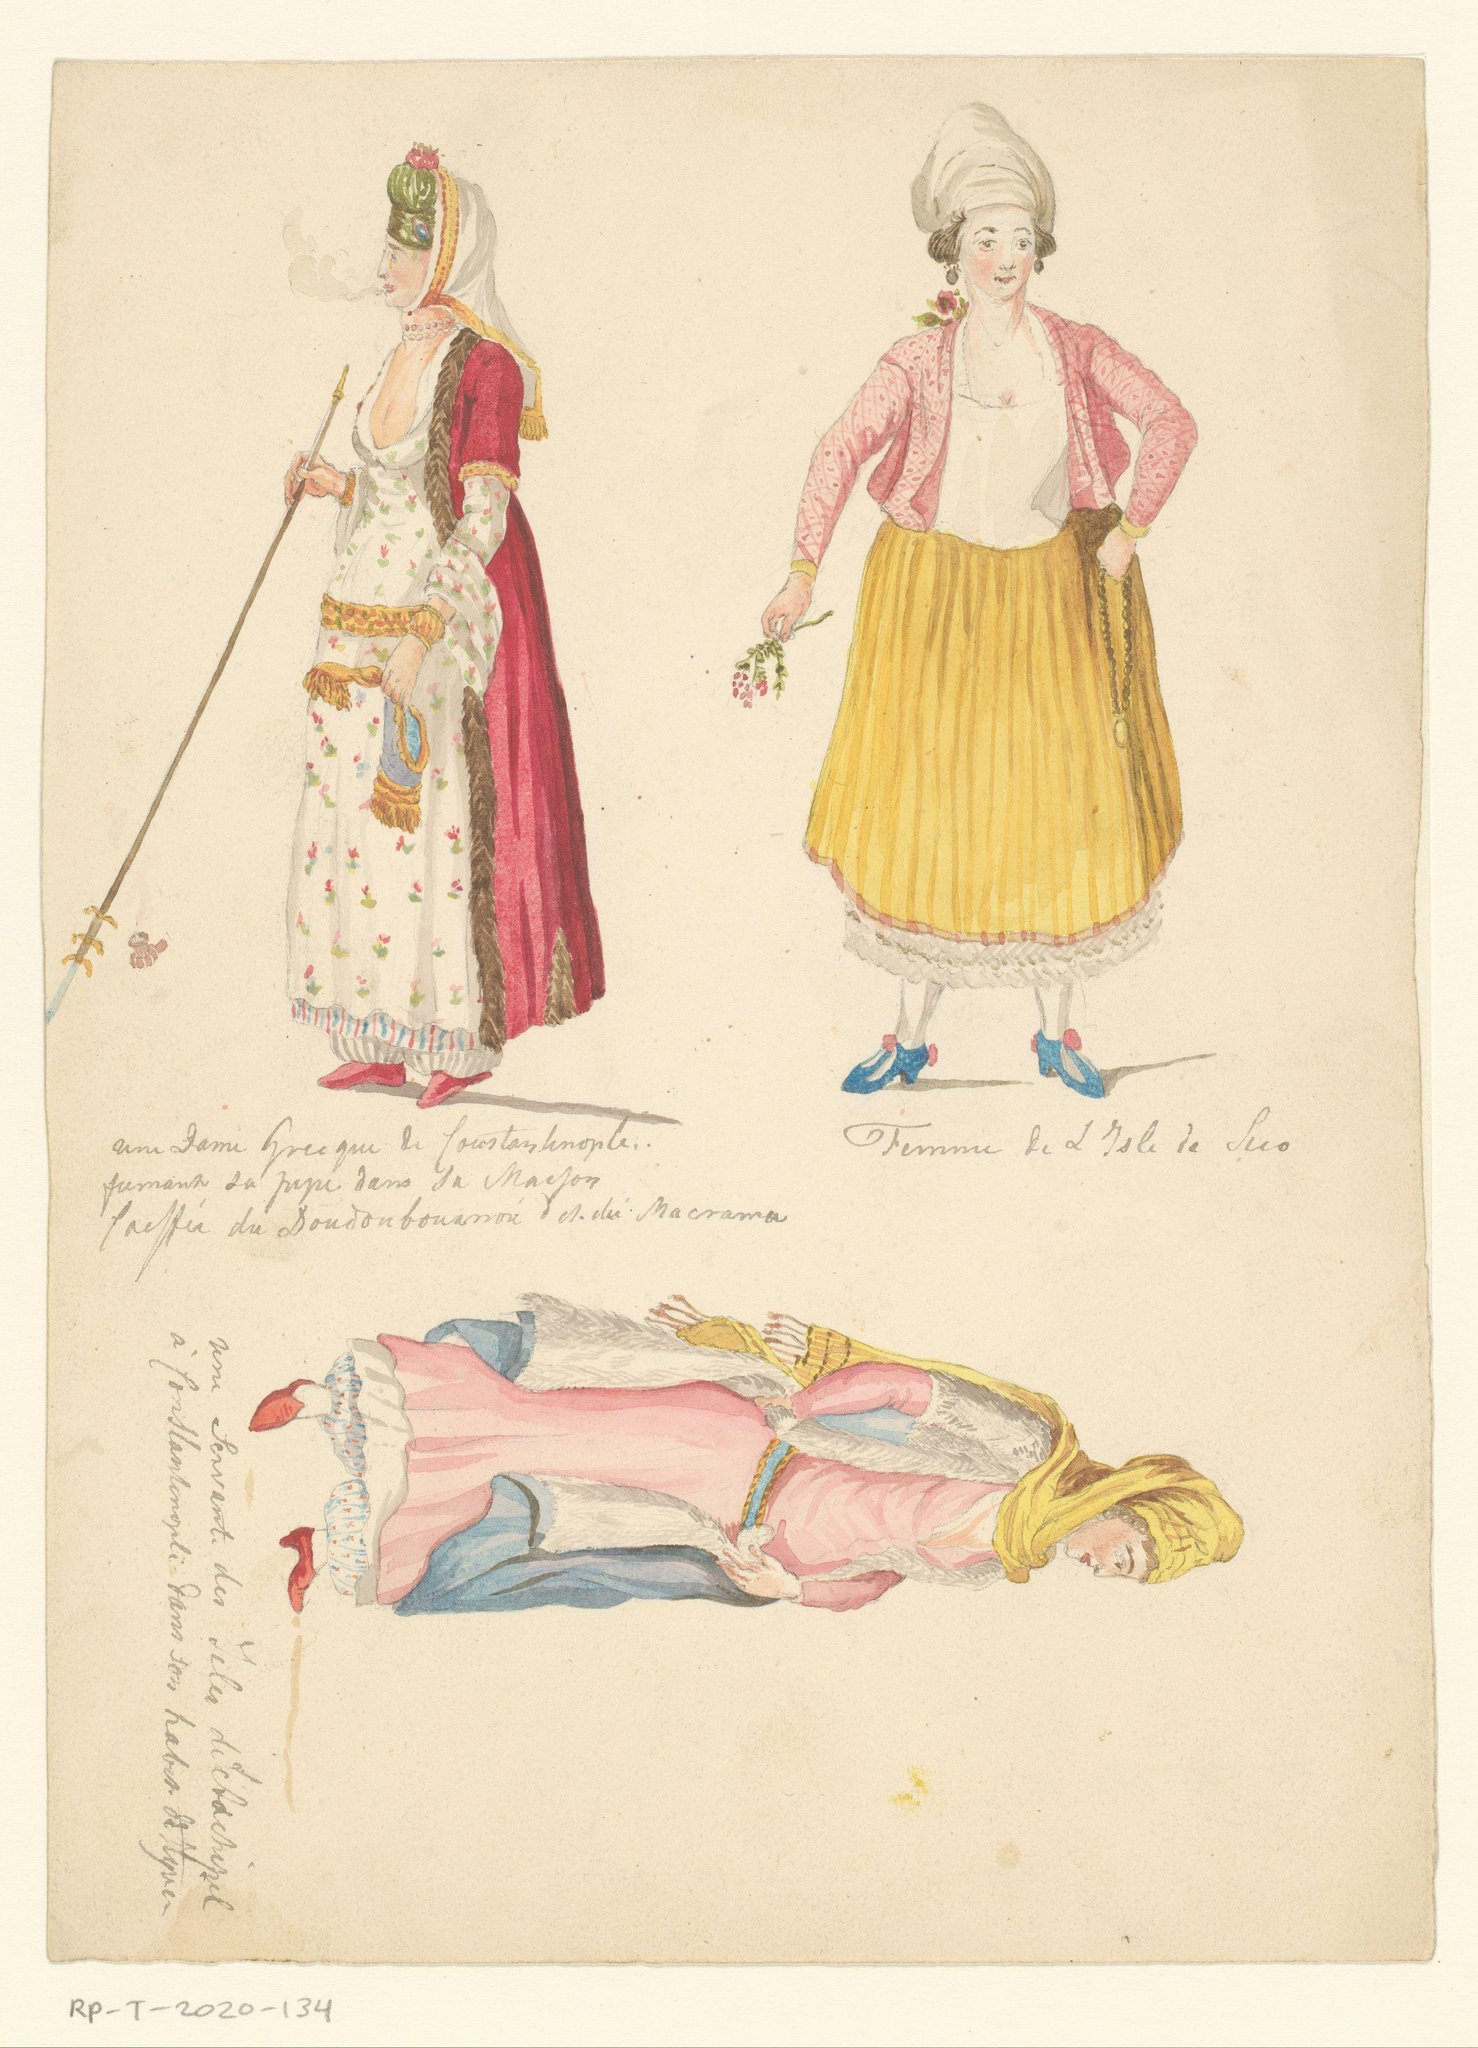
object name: drawing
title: Pijprokende vrouw, vrouw met bloem en dienstmeisje uit Istanboel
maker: Anonymous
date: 1750-1850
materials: gouache, paper, pencil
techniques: brush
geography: france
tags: cut flowers; nosegay, bunch of flowers, folk costume, regional costume, pipe ~ tobacco (+ taking (particular) foodstuffs: eating, drinking, smoking, chewing, etc.), maid ~ house personnel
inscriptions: collector's mark: Lugt 2228, inscription: ‘Une Dami Grec qui [...] Constantinople fumant sa pipe dans la Maison (...)/ Femme de L'Isle de [...]/ une Servant des Isles de Archipel a Constantinople dans son habit de [...]’